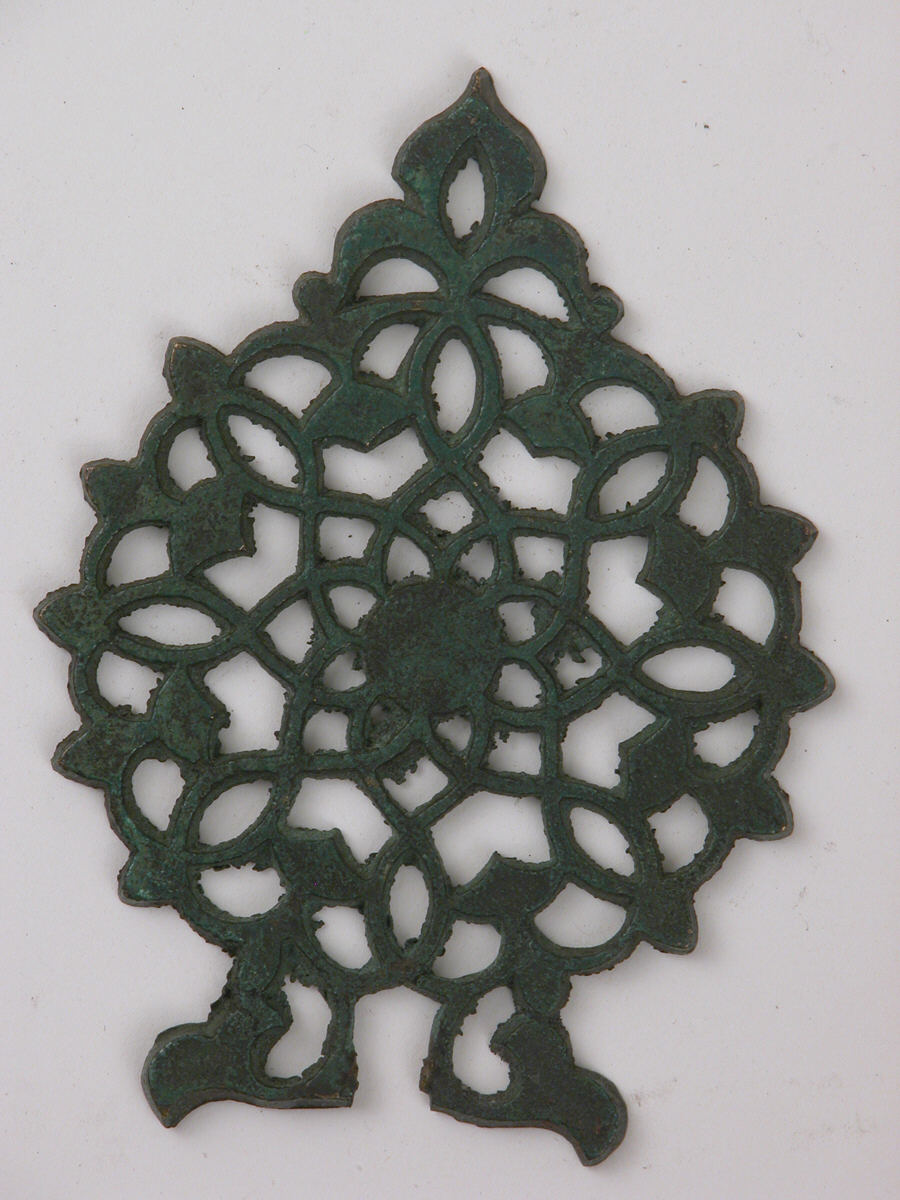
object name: ornament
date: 1201-1300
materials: bronze, patina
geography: egypt